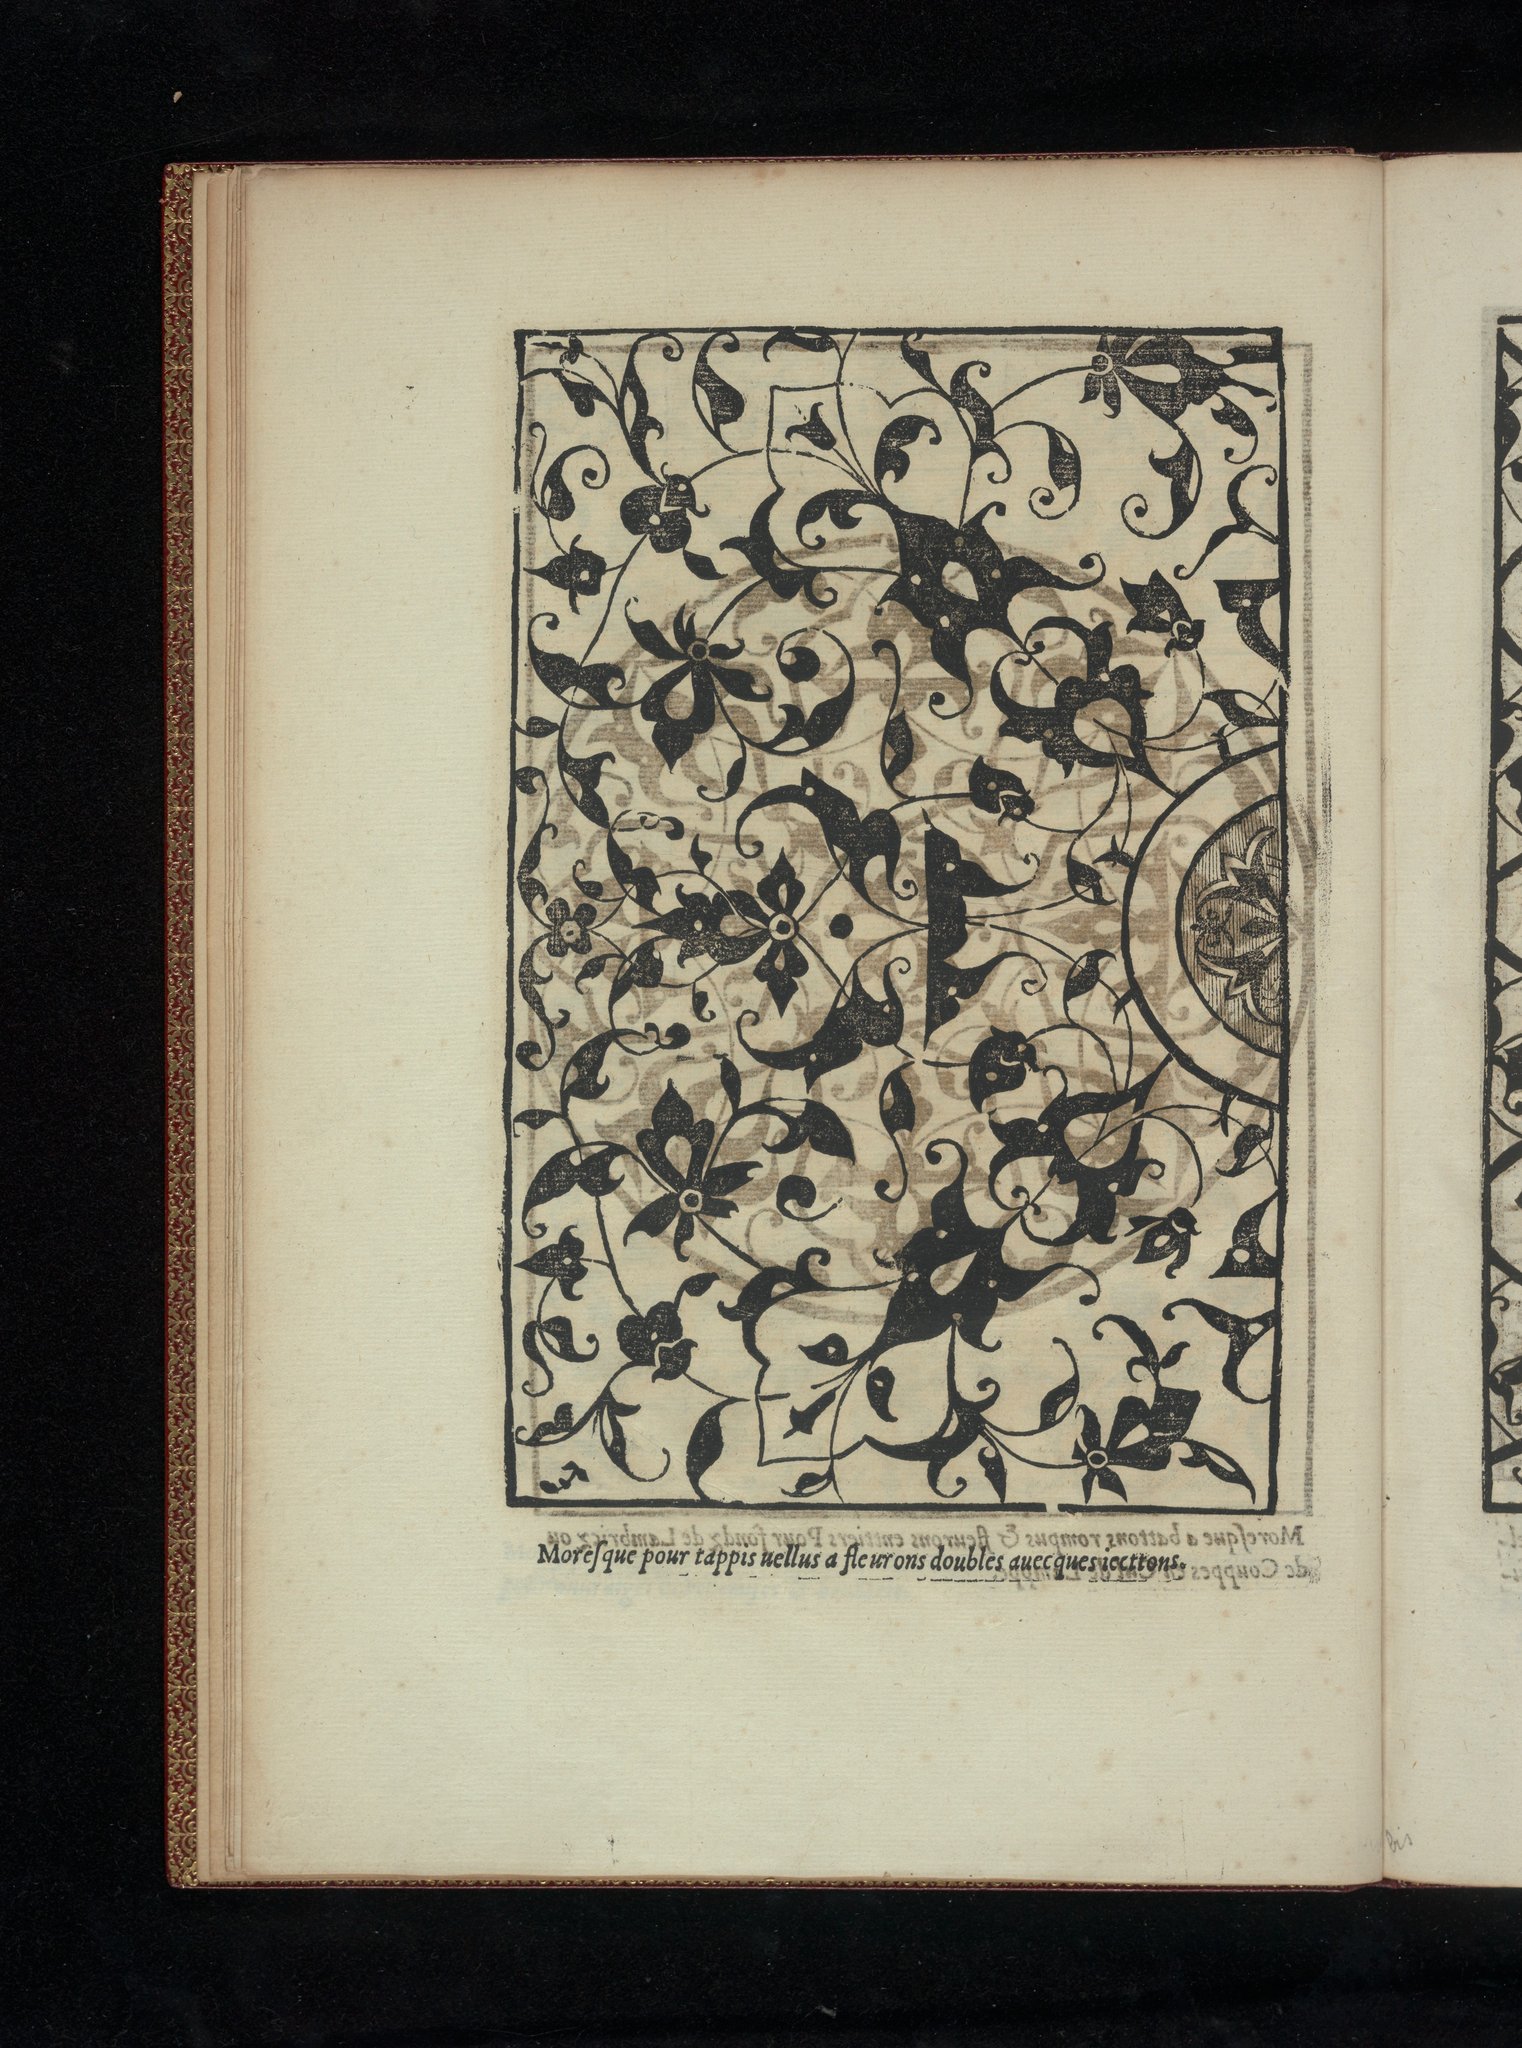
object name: book print ornament architecture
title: Livre de Moresques, page 4 (recto)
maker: francesco di pellegrino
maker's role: artist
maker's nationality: italian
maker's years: 1525-1552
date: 1546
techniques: woodcut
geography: france